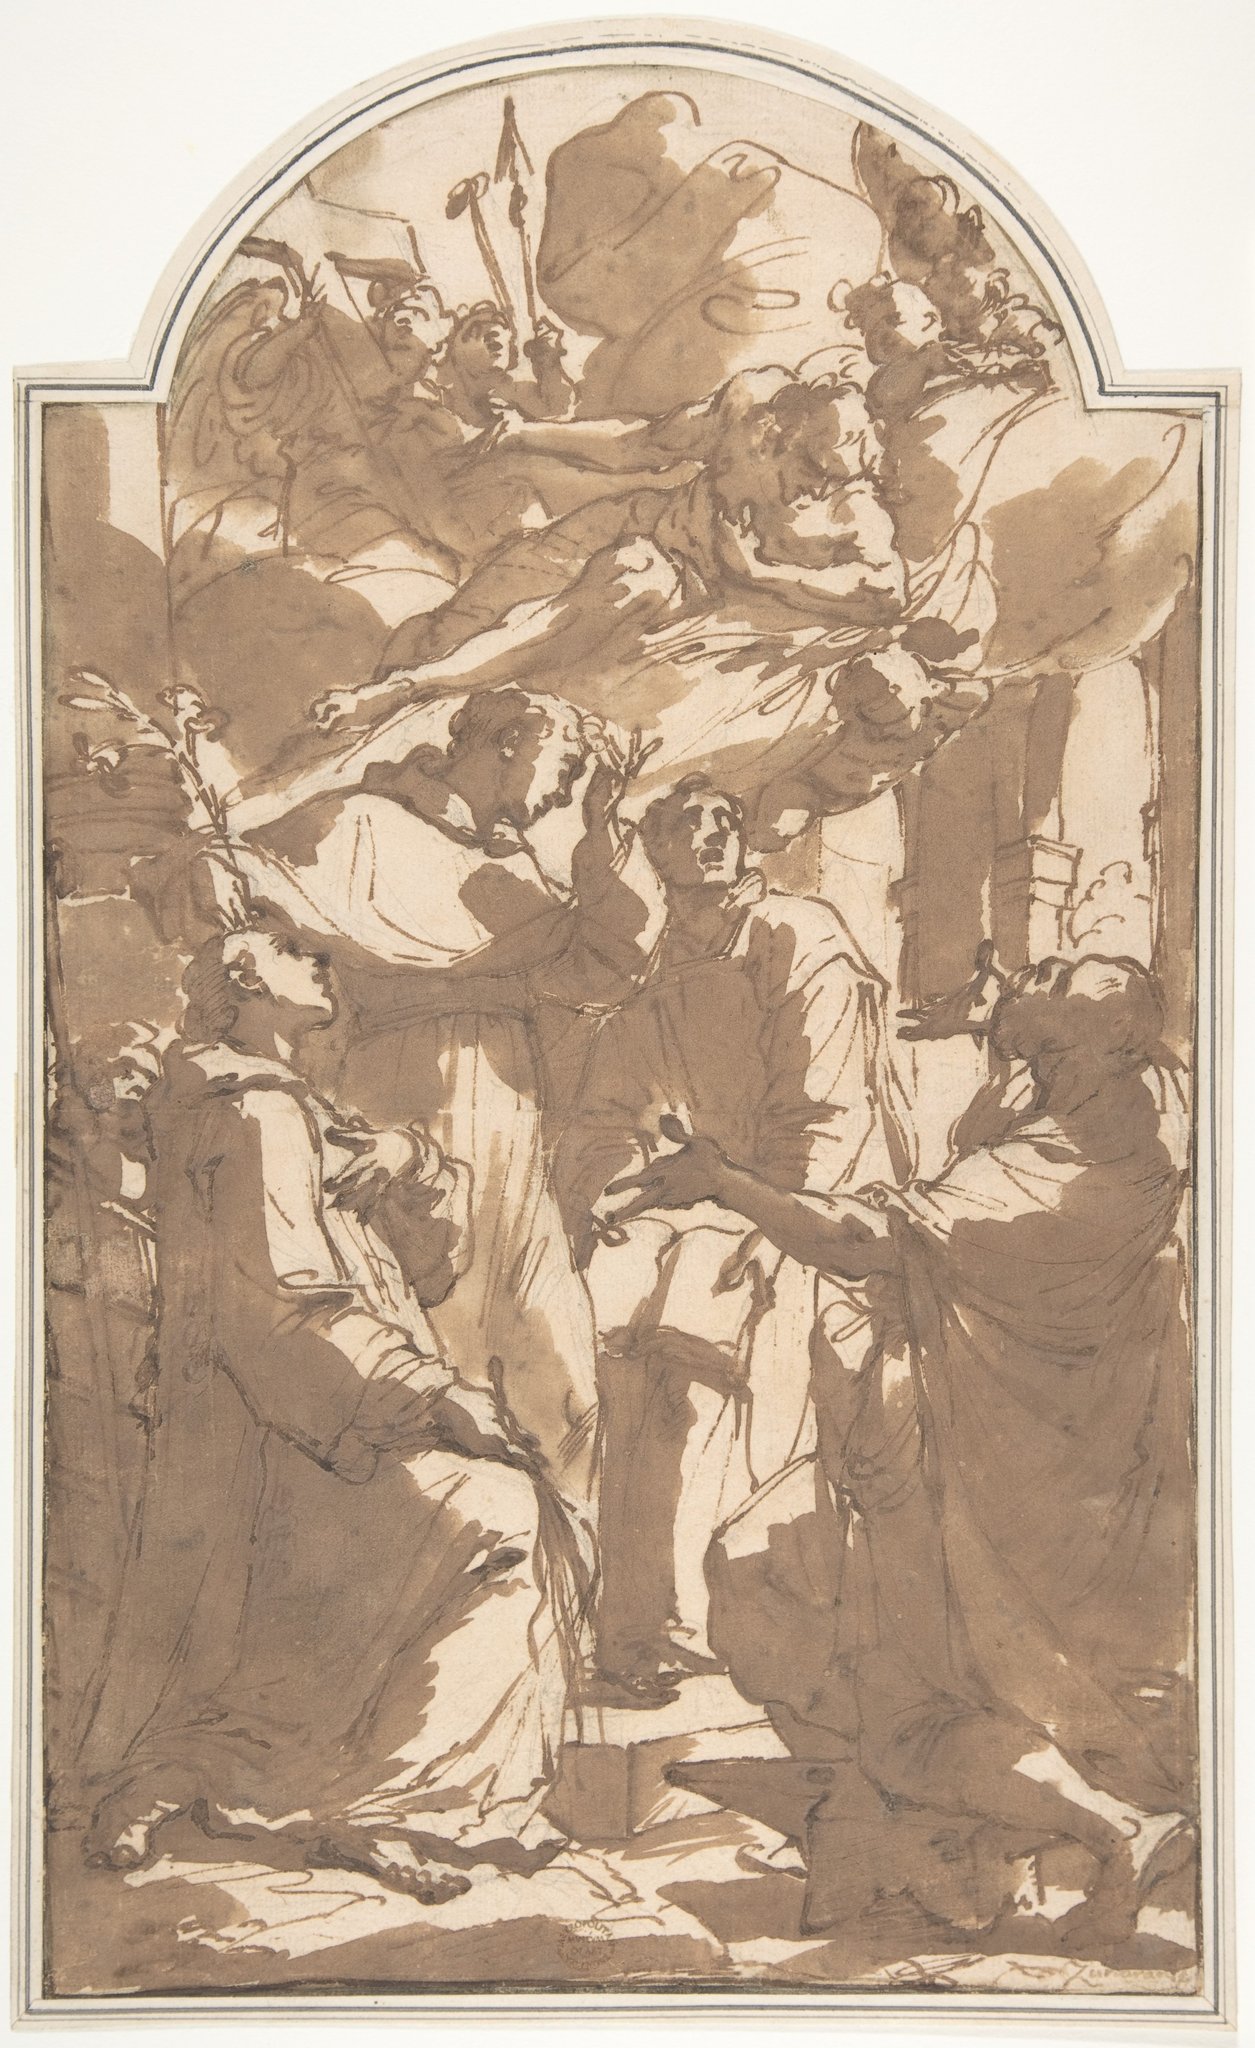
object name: drawing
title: Christ in Glory with Saint Lawrence, Saint Anthony of Padua, Saint Ignatius of Loyola, and Saint Eligius.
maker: ubaldo gandolfi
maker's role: artist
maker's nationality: italian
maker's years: 1728-1781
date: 1766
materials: graphite, ink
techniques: brush, pen, wash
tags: christ,saint anthony,saint lawrence,saints